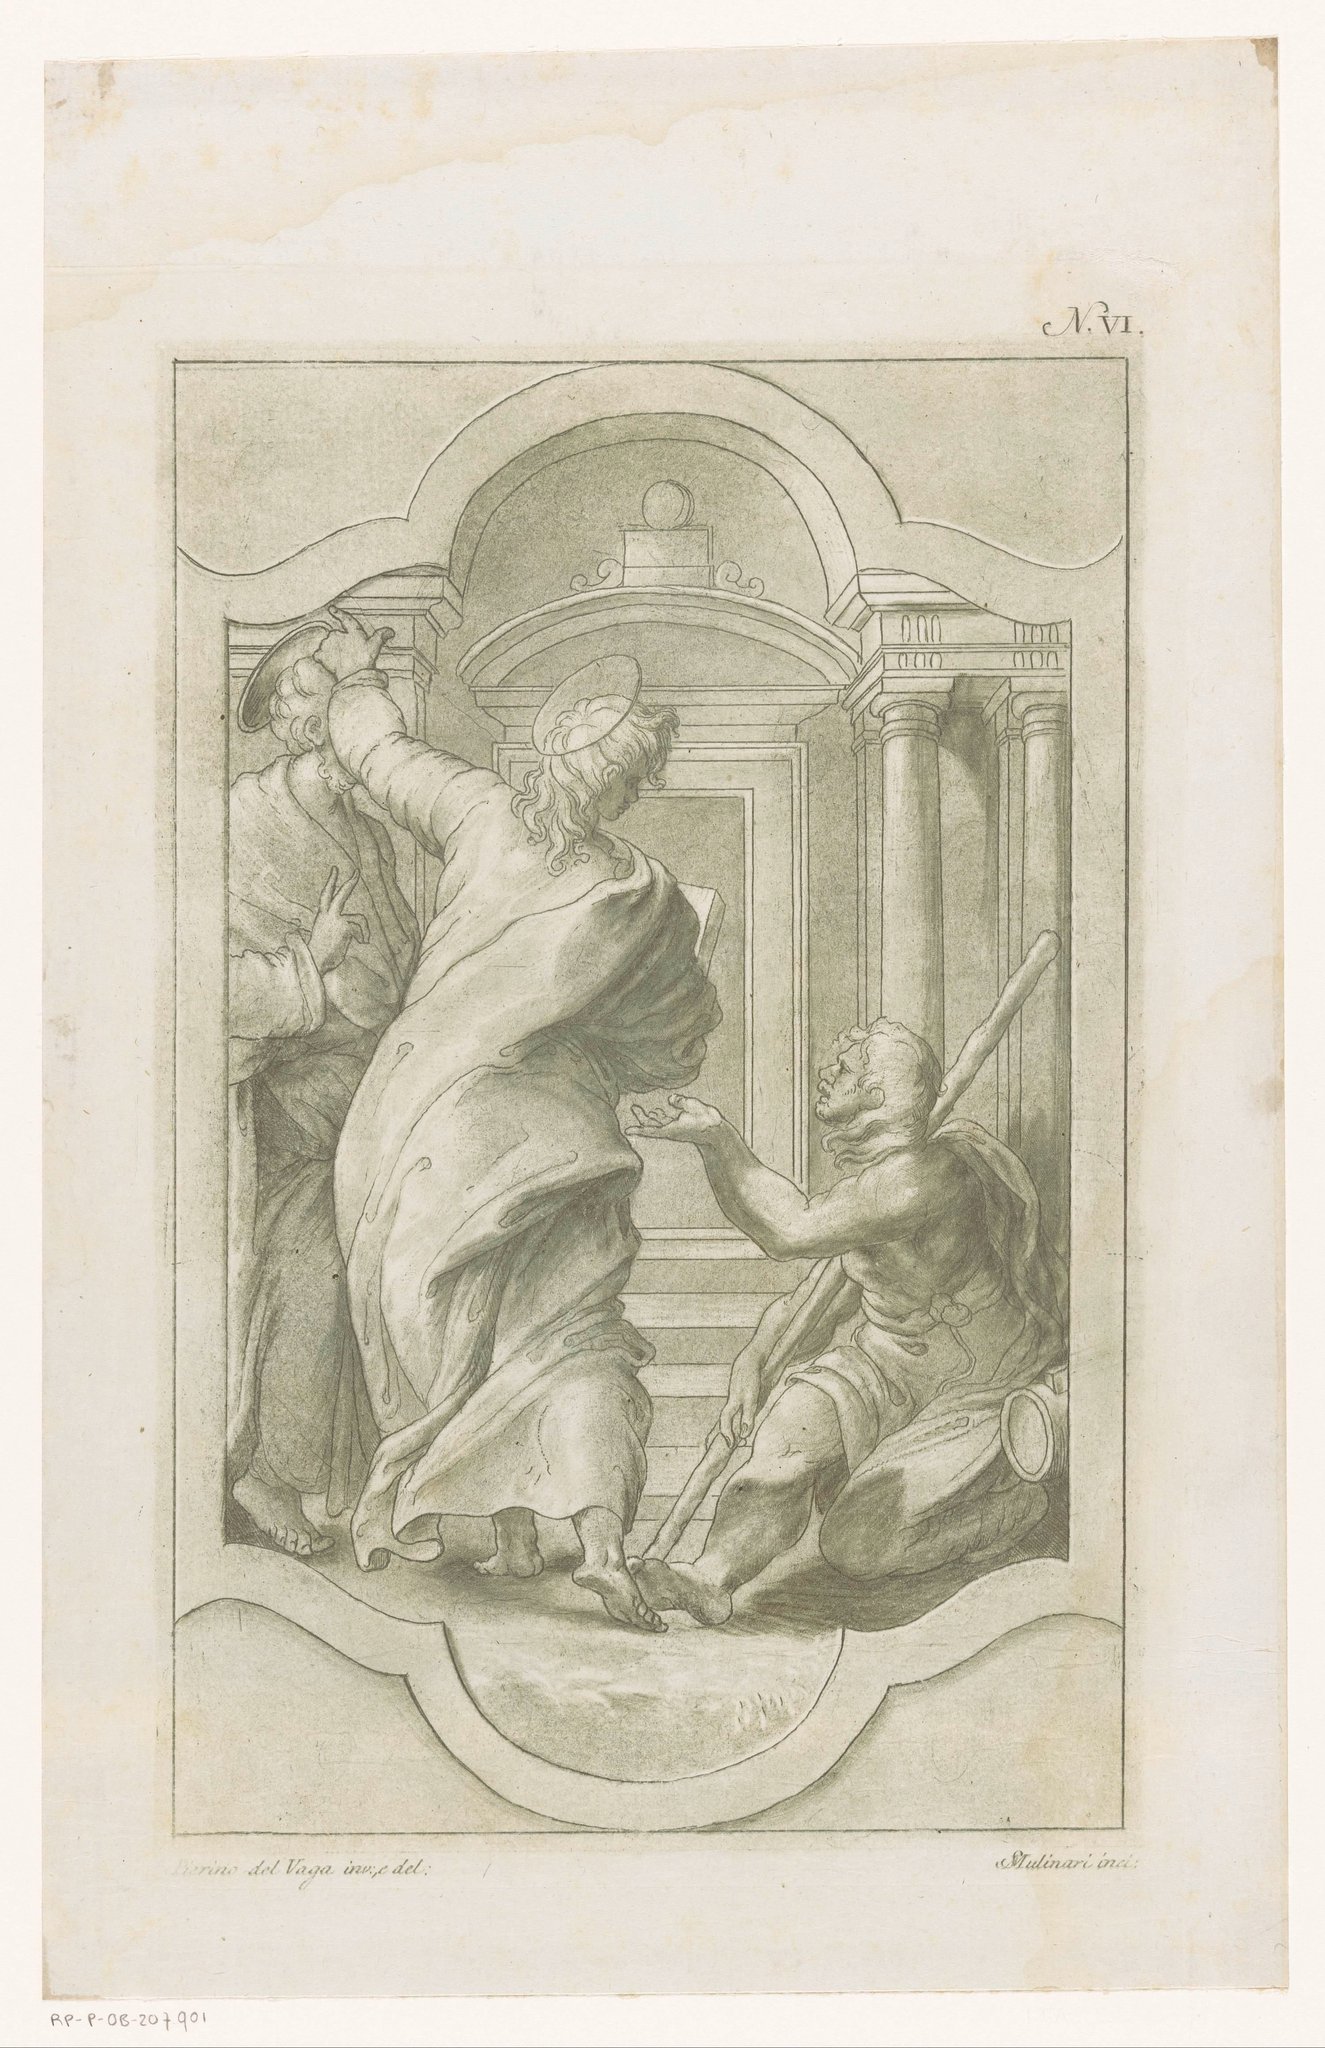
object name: print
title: De heilige Petrus en Johannes genezen een lamme in een tempel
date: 1751-1790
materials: paper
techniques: aquatint, etching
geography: italy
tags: healing of a lame beggar at the beautiful gate of the temple by peter and john (acts 3 - 4:31)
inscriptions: collector's mark: Lugt 2228